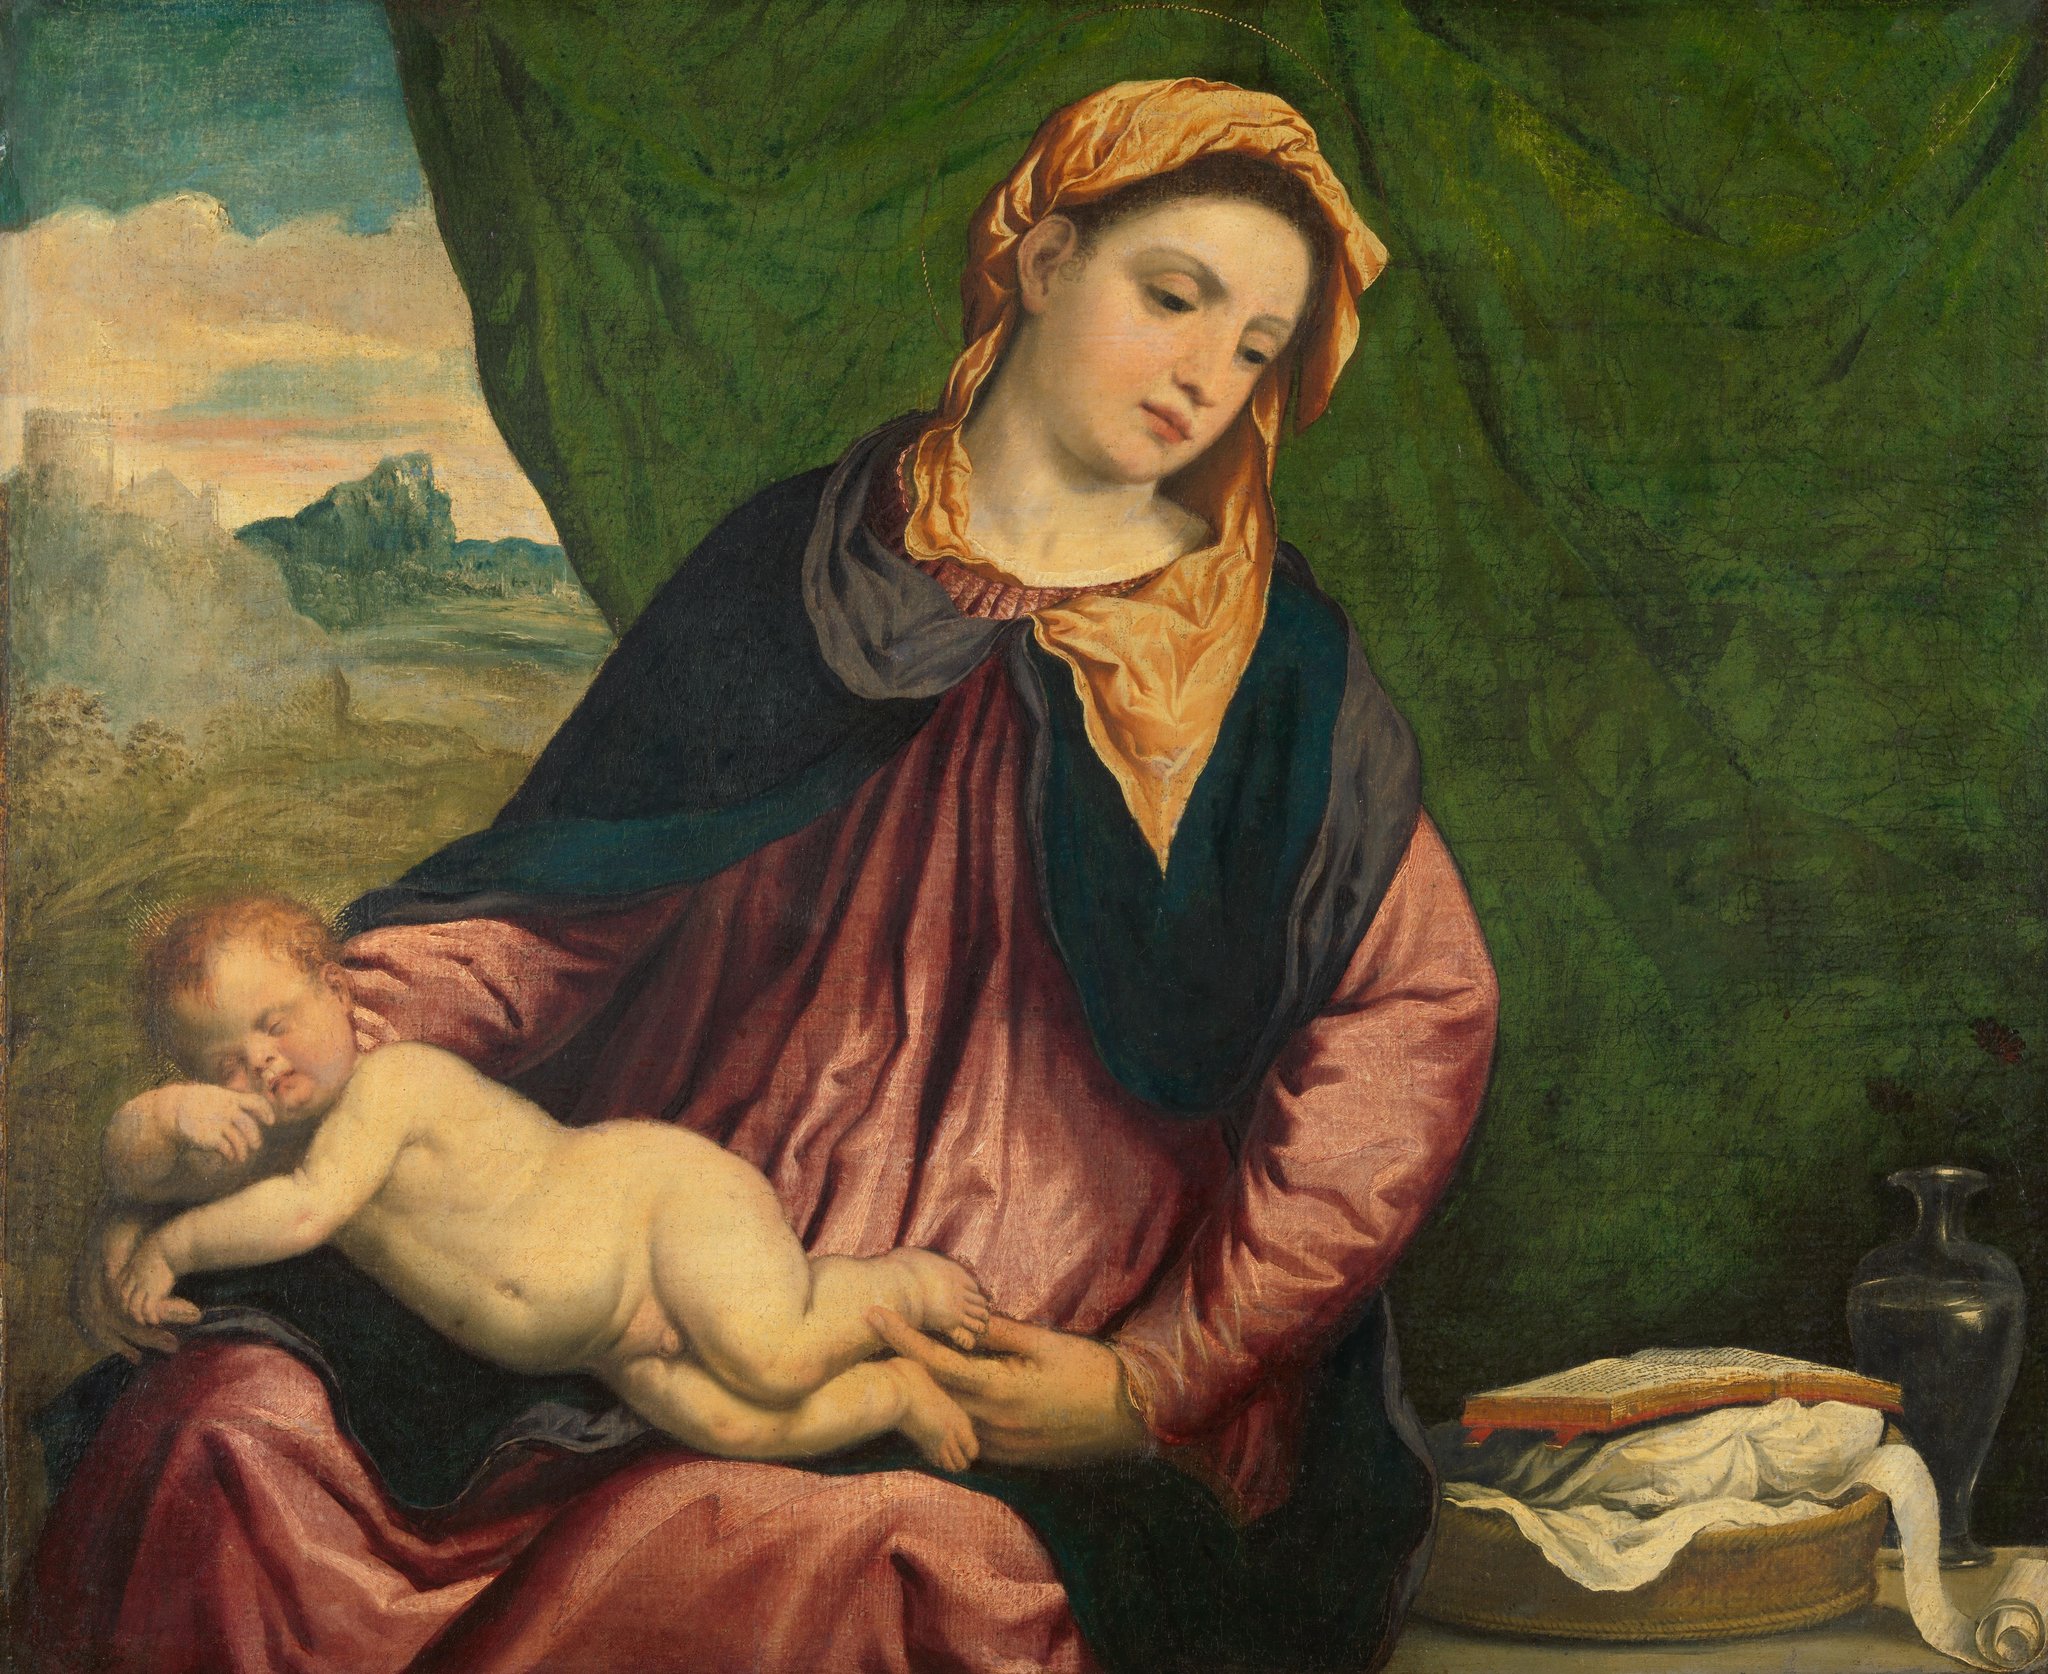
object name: painting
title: Madonna with Sleeping Child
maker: paris bordone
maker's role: draughtsman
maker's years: 1500-1571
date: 1540-1560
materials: canvas, oil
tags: madonna: mary sitting or enthroned, the christ-child in her lap (or in front of her bosom) (mary sometimes represented half-length), reading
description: Madonna met slapend kind. Maria zittend met het Christuskind liggend slapend op haar schoot. Zij leest in een opengeslagen boek dat op een mand met bindselen ligt.